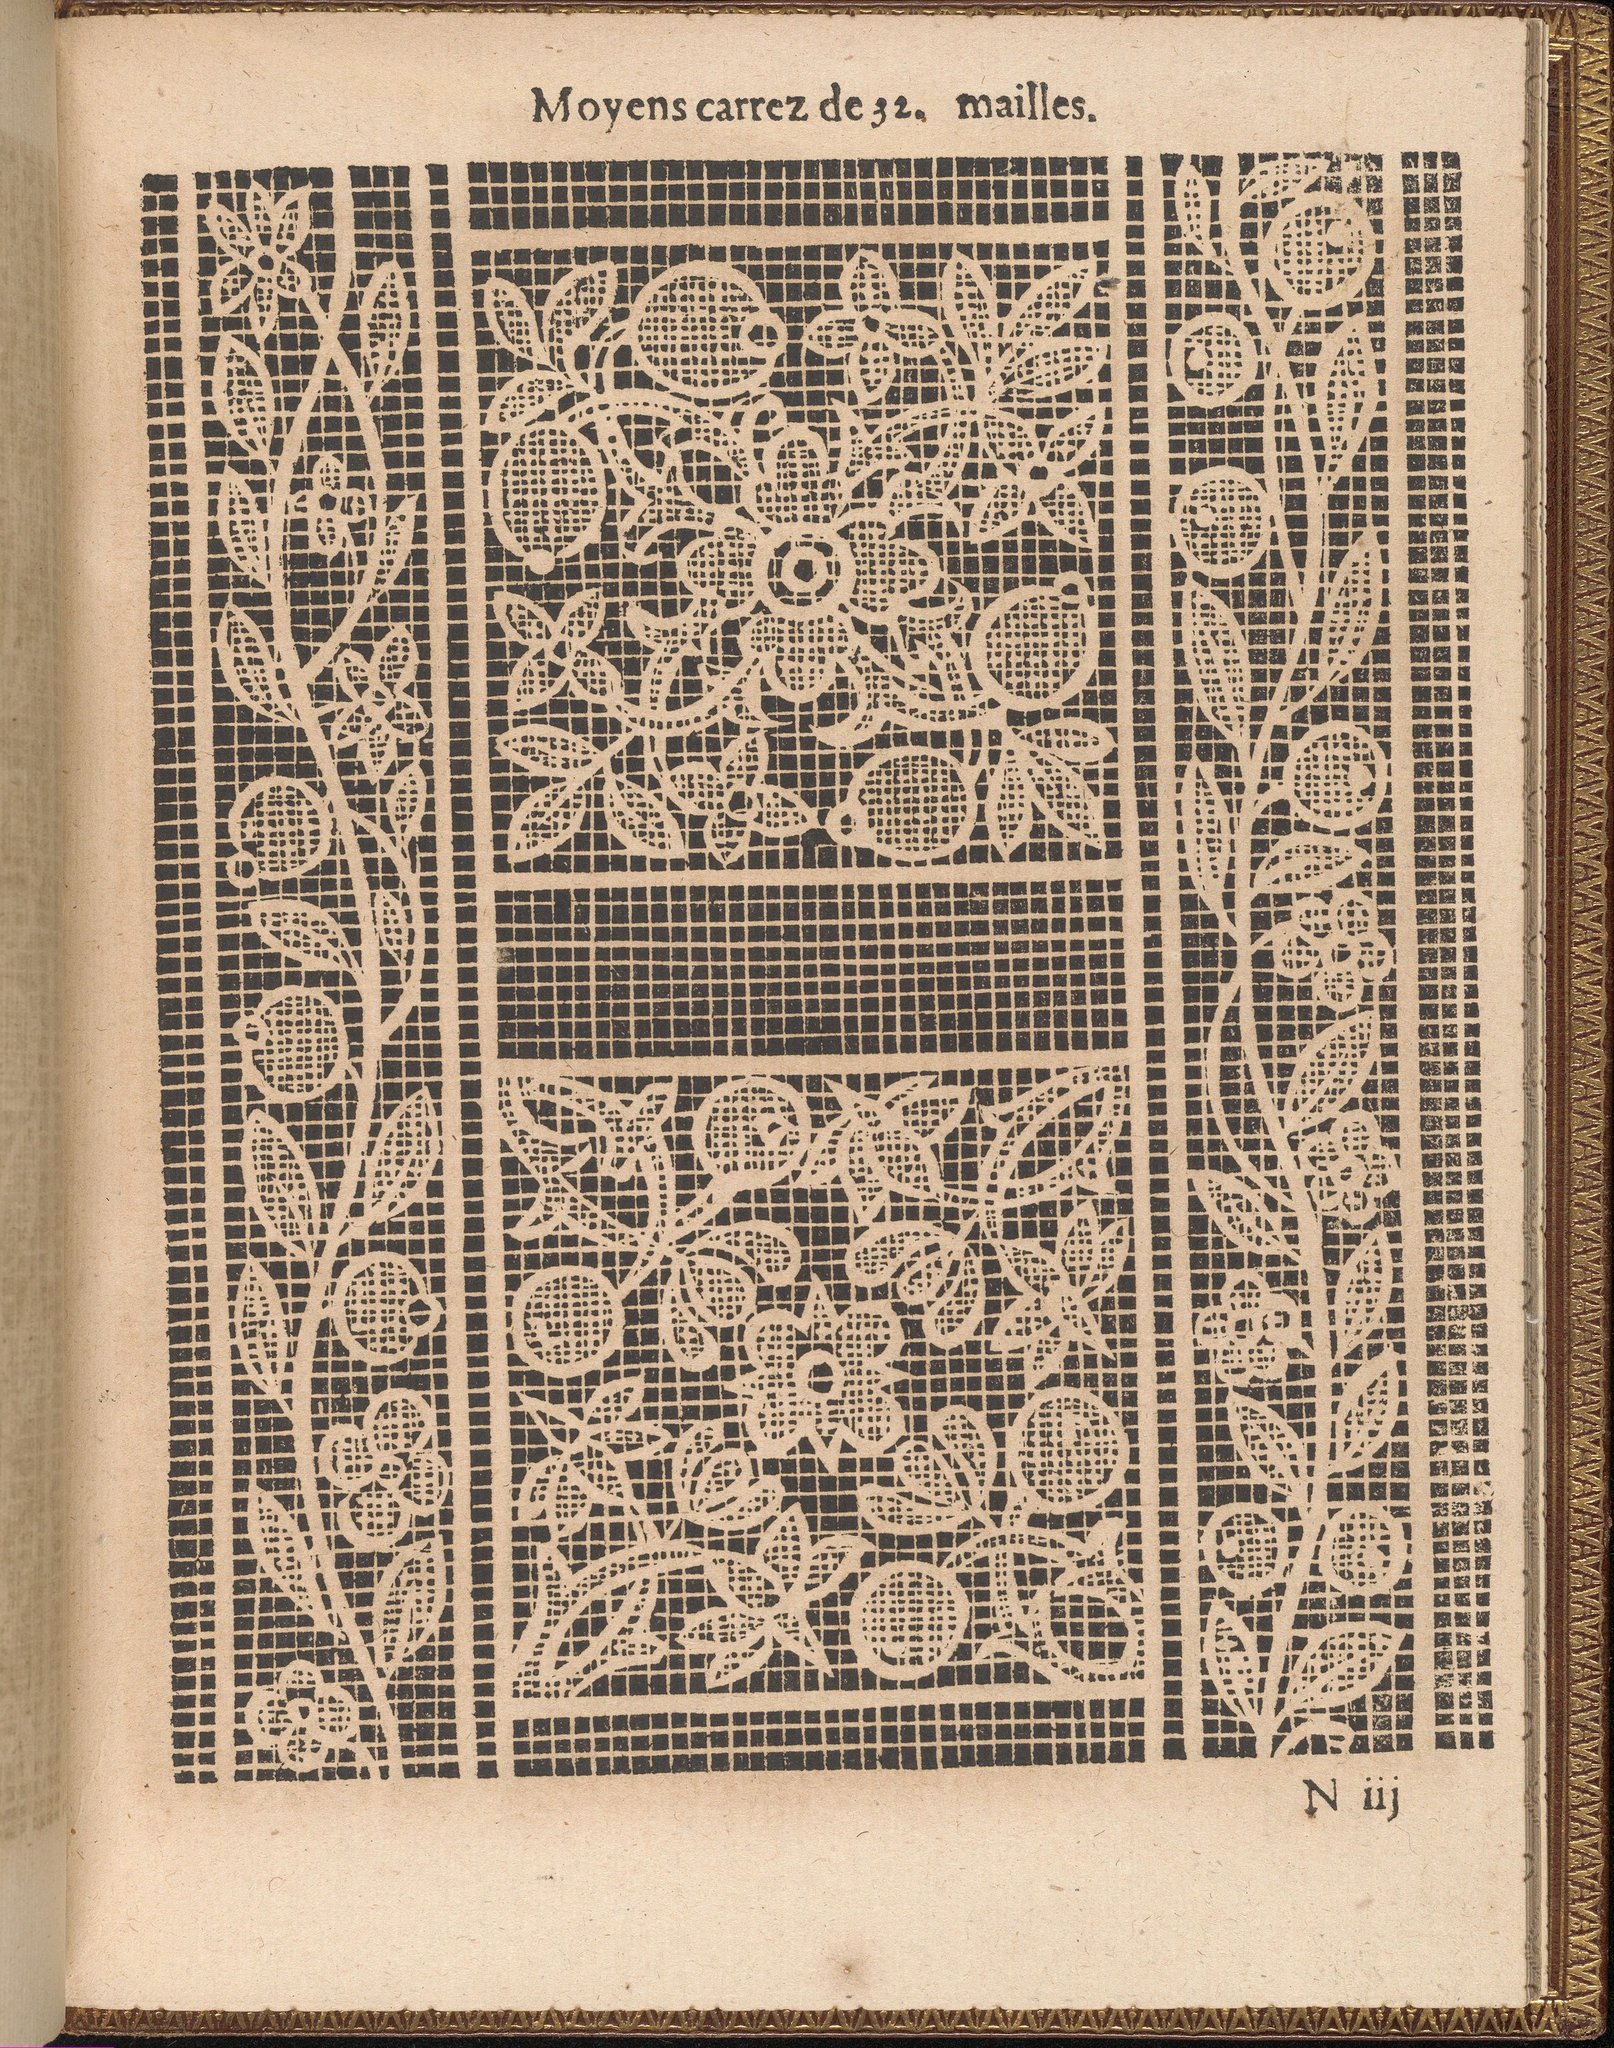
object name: book print ornament architecture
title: La Pratique de l'Aiguille, page 50 (recto)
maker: matthias mignerak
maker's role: author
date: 1605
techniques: woodcut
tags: fruit,flowers